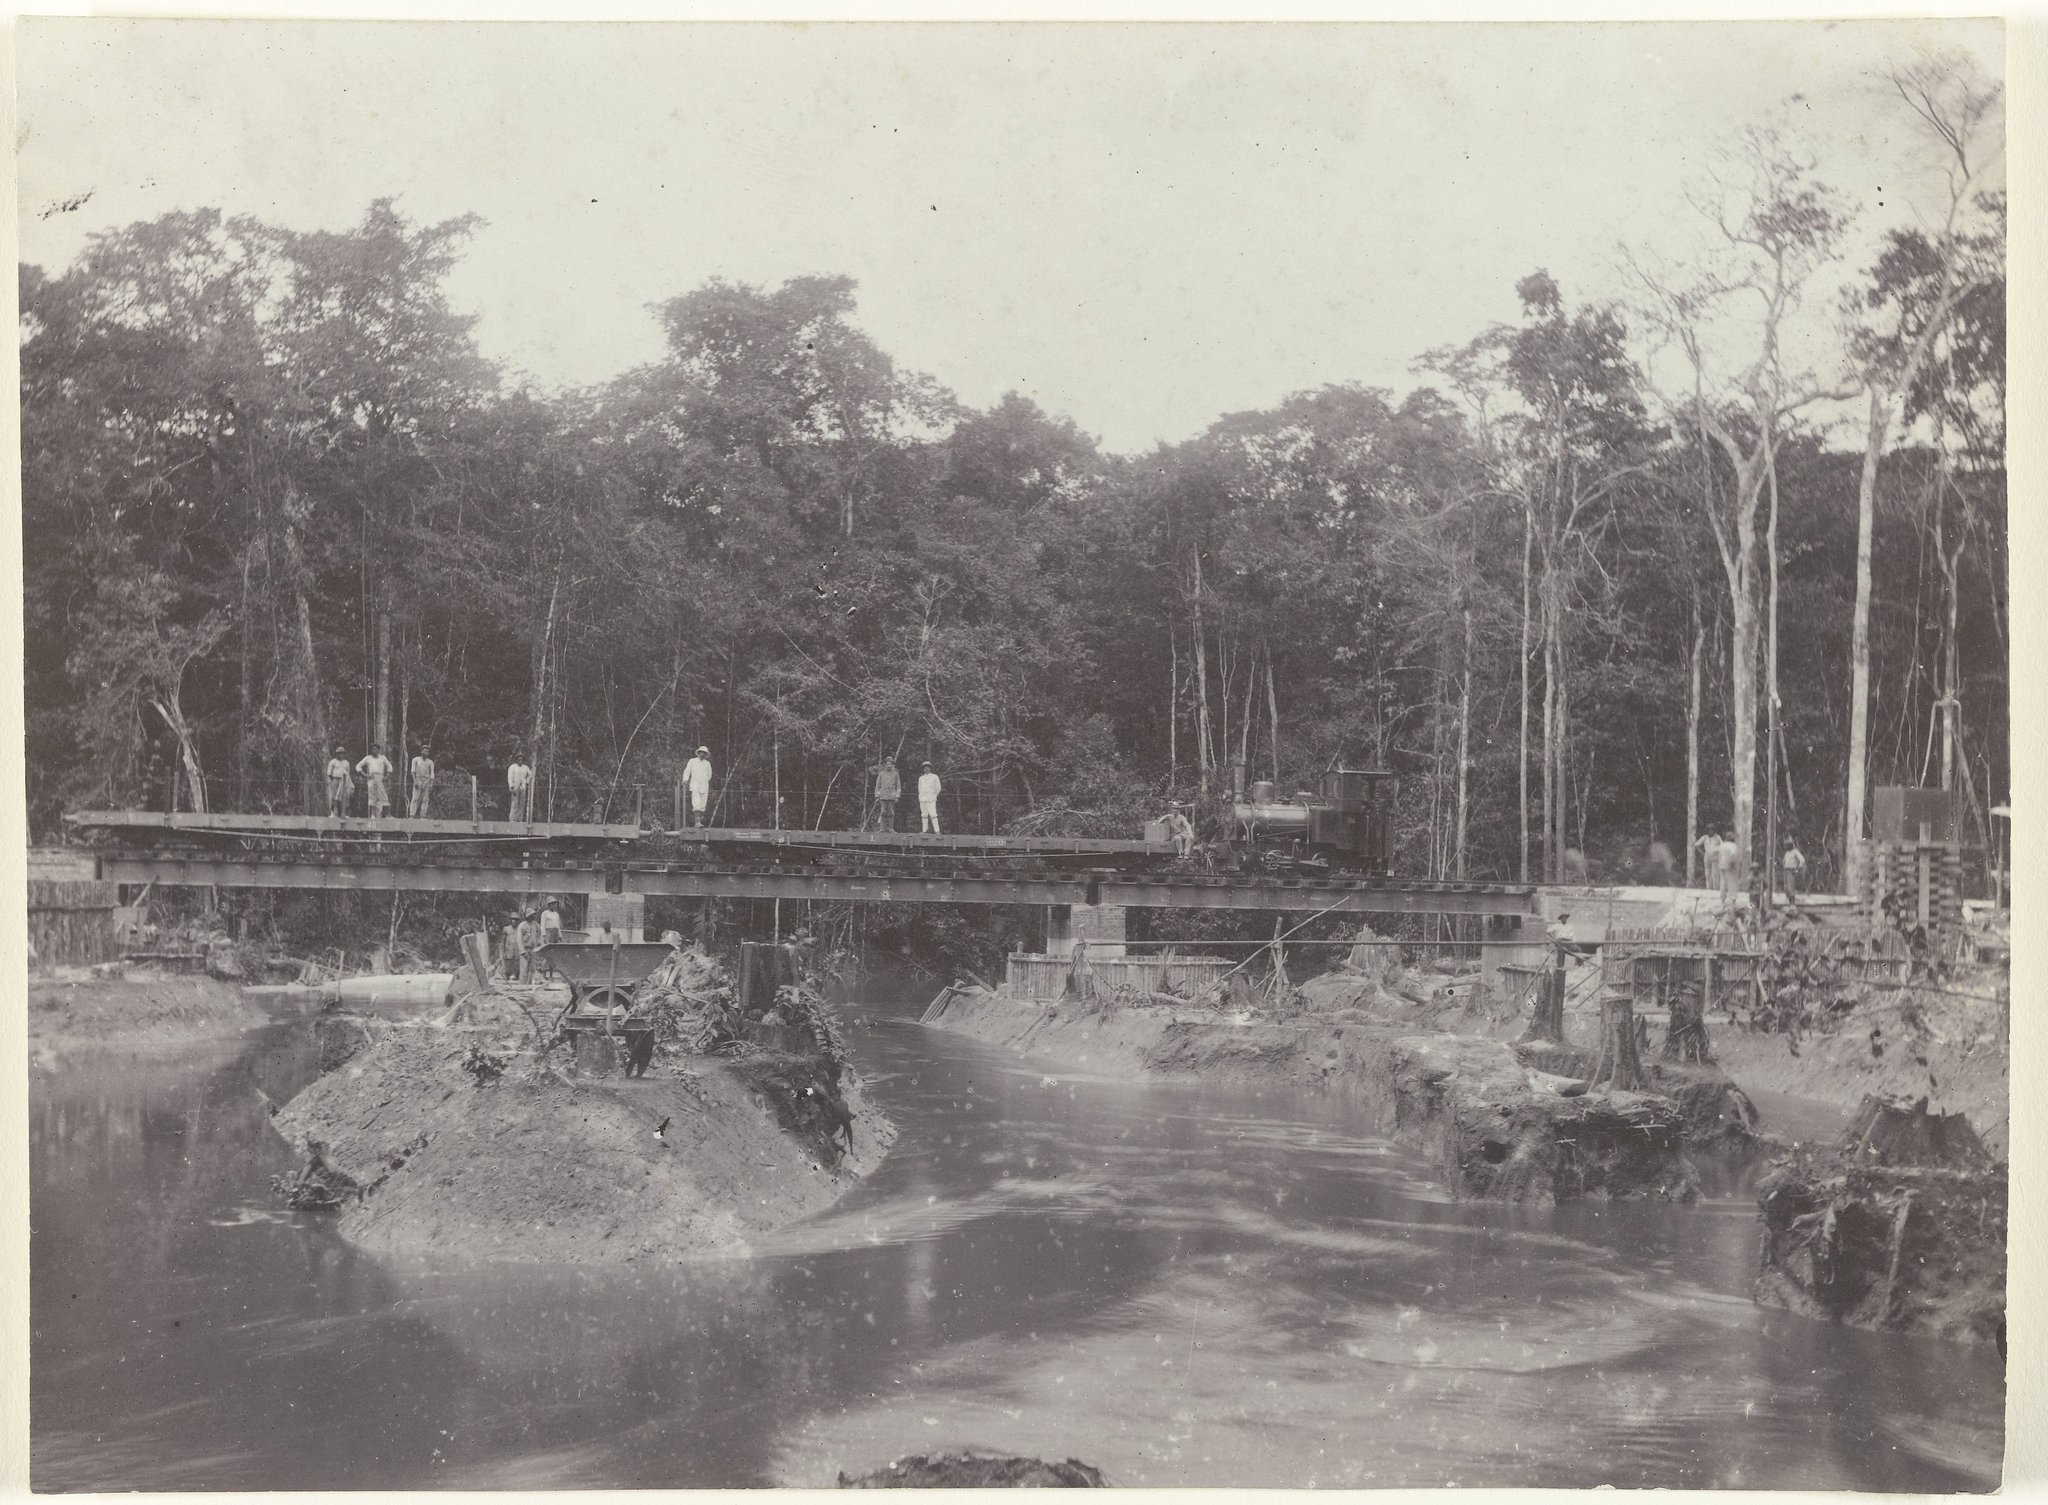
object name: photograph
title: Aanleg van de Lawaspoorweg over de Witti Watra in Suriname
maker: Anonymous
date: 1910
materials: photographic support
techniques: photography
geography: suriname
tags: amsterdam, theodoor brouwers, suriname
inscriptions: inscription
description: Brug over rivier, waarop aantal mannen. Aanleg van de Lawaspoorweg over de Witti Watra in Suriname.